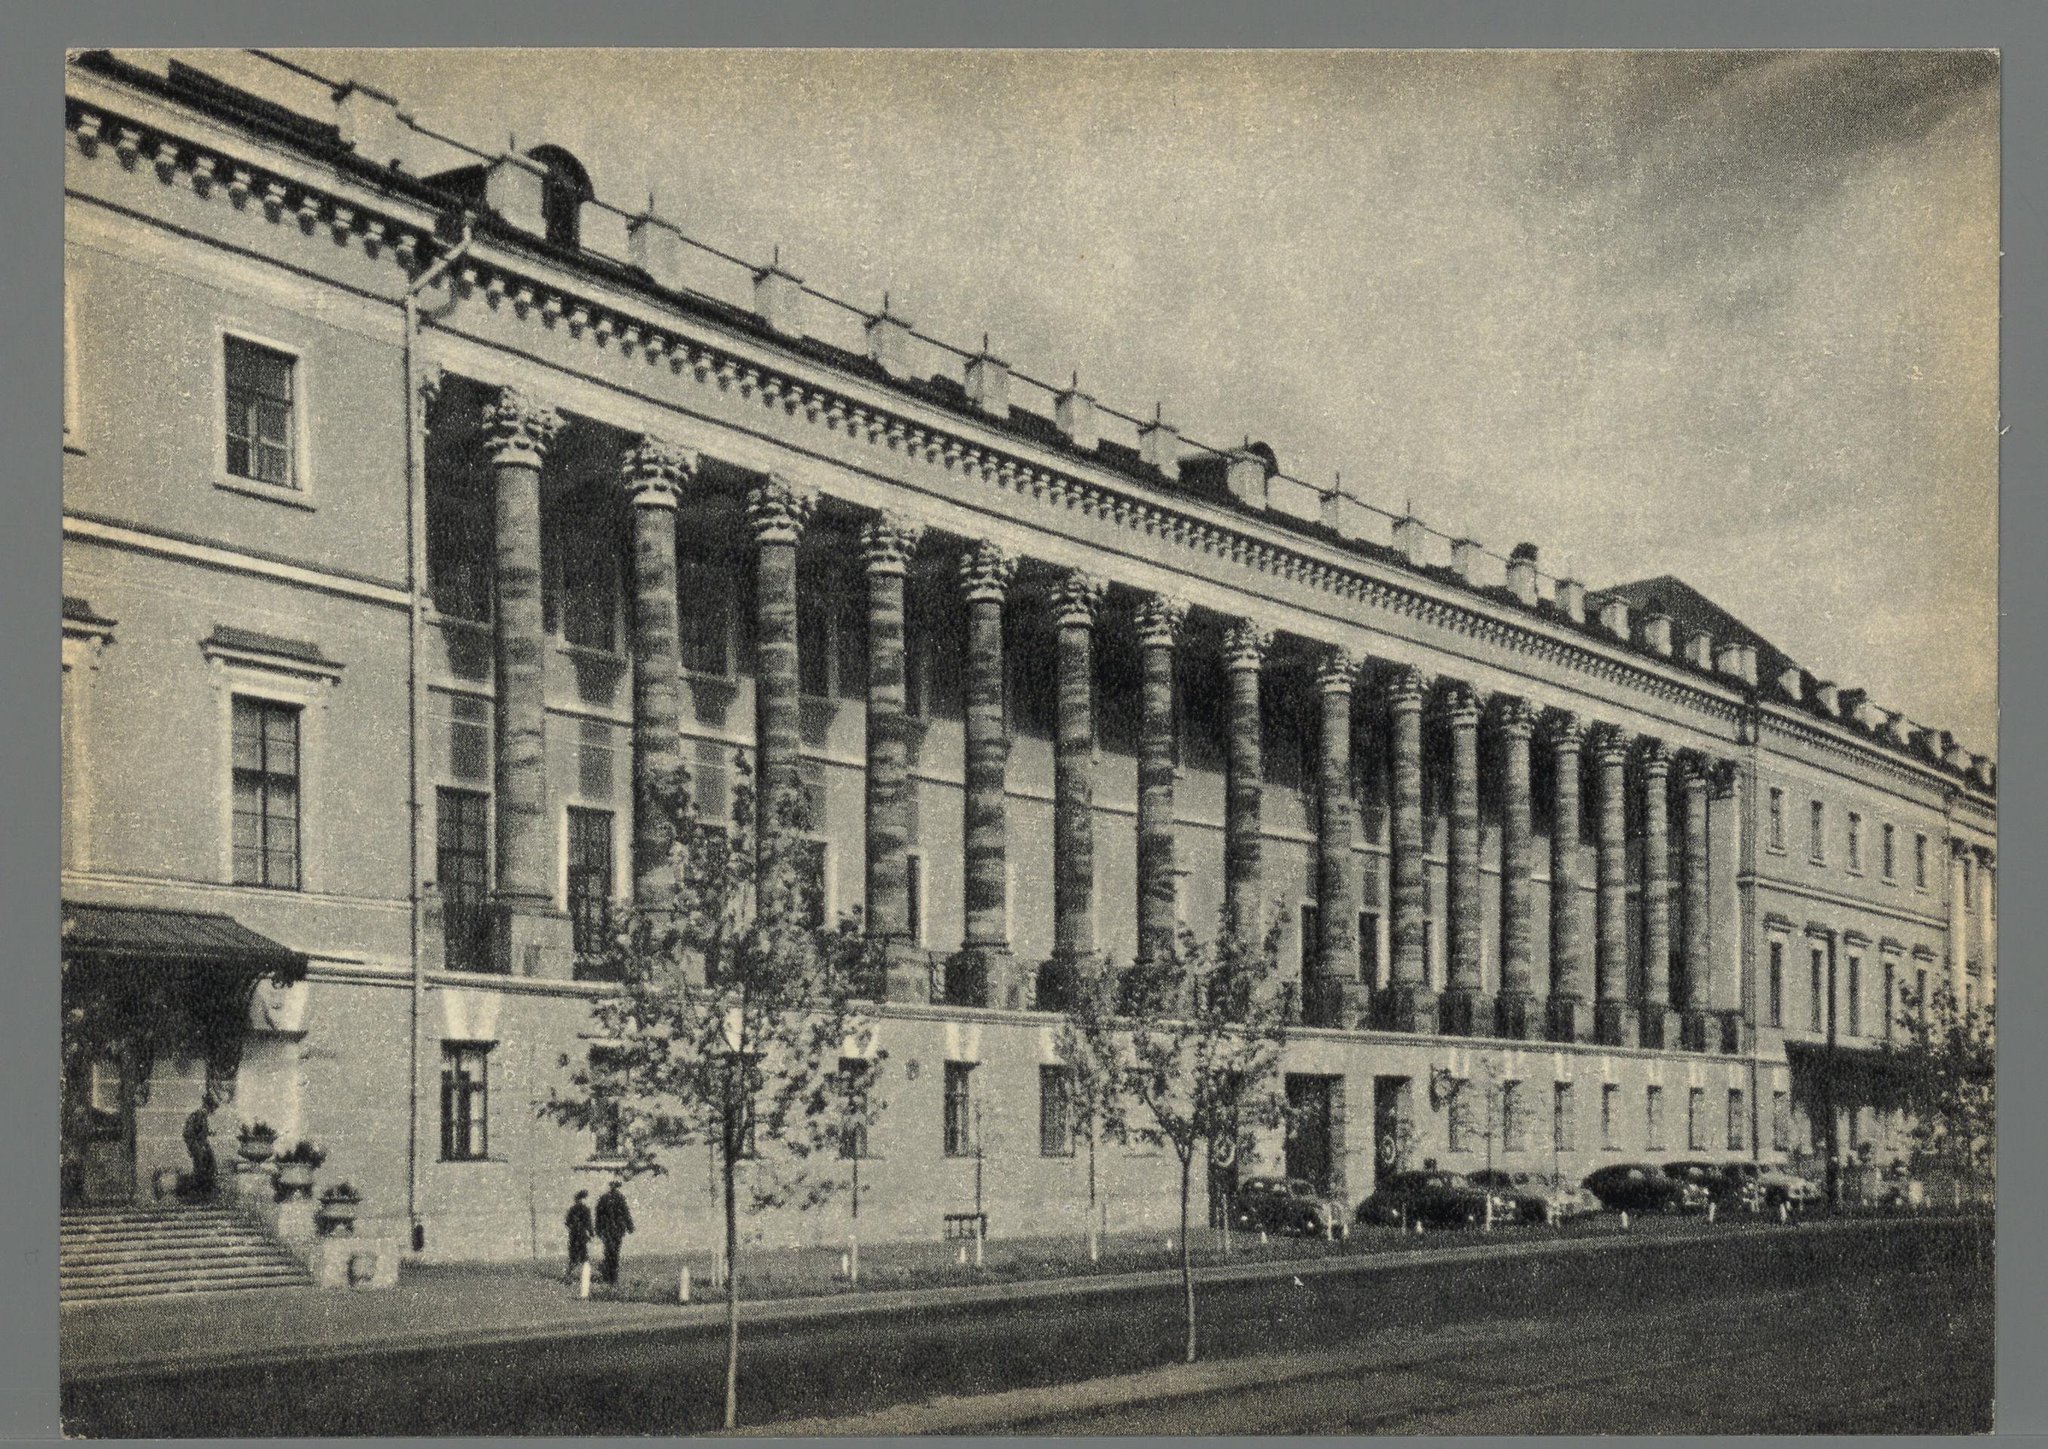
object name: photomechanical print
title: Gezicht op het Catharinapaleis te Moskou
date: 1957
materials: cardboard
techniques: rotogravure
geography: moscow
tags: palace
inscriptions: date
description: De titel op object staat in het Russisch.